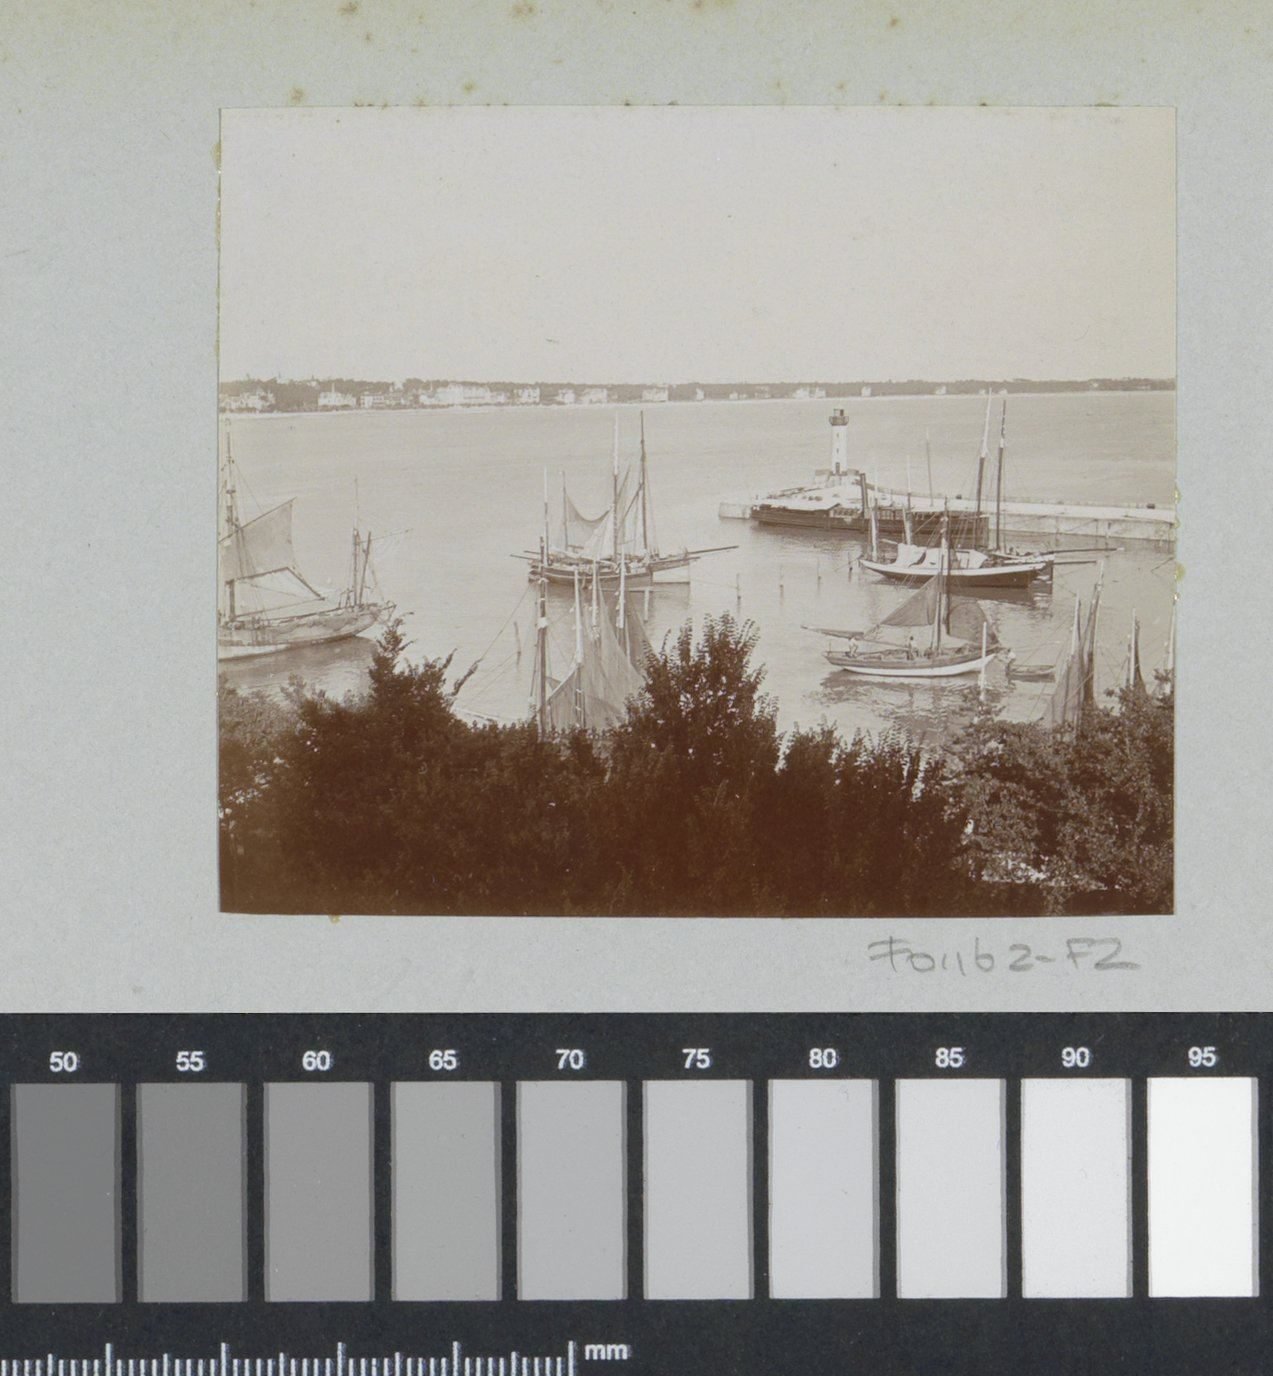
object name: photograph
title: Gezicht op een haven in Frankrijk met zeilboten en havenhoofd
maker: Anonymous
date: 1905-1910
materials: paper, photographic support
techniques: gelatin silver print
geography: france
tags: sailing-ship, sailing-boat, harbour (+ view ~ vehicle, ship, etc.), pier, quay, wharf, france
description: Onderdeel van Fotoalbum van een Franse amateurfotograaf met bezienswaardigheden in Frankrijk, Zwitserland en Italië.